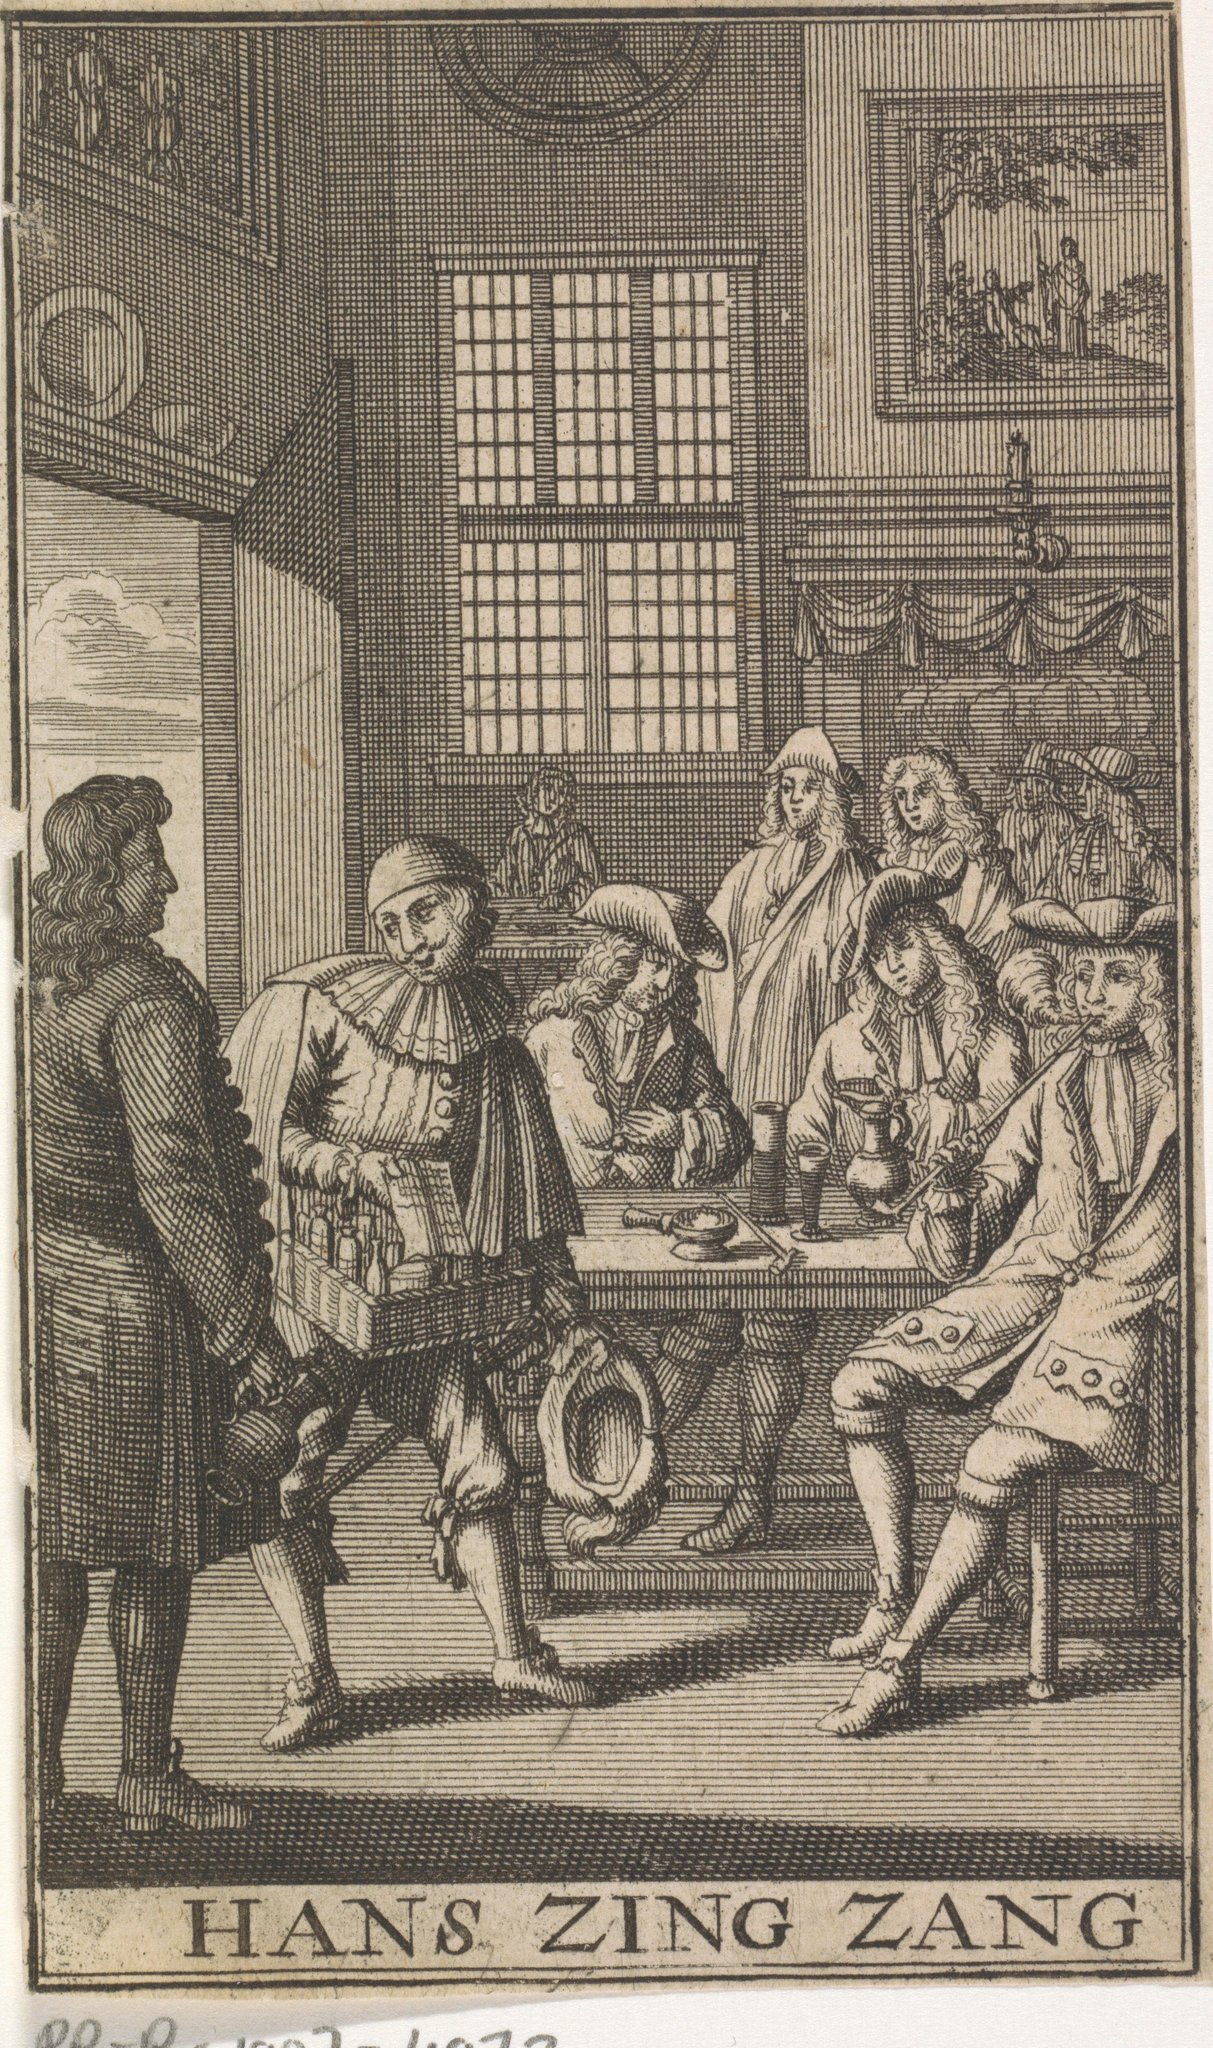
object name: print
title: Marskramer in een herberg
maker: Anonymous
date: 1710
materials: paper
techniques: etching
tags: inn, coffee-house, public house, etc., pedlar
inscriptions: collector's mark: Lugt 2228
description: Titelpagina voor: Pook, Jan. De hollebollige lagchende dokter. Of De bereysde Hans Zing-Zang (...), kamer-spel. Amsterdam: Timotheus ten Hoorn of weduwe Timotheus van Hoorn, 1710 of 1715.